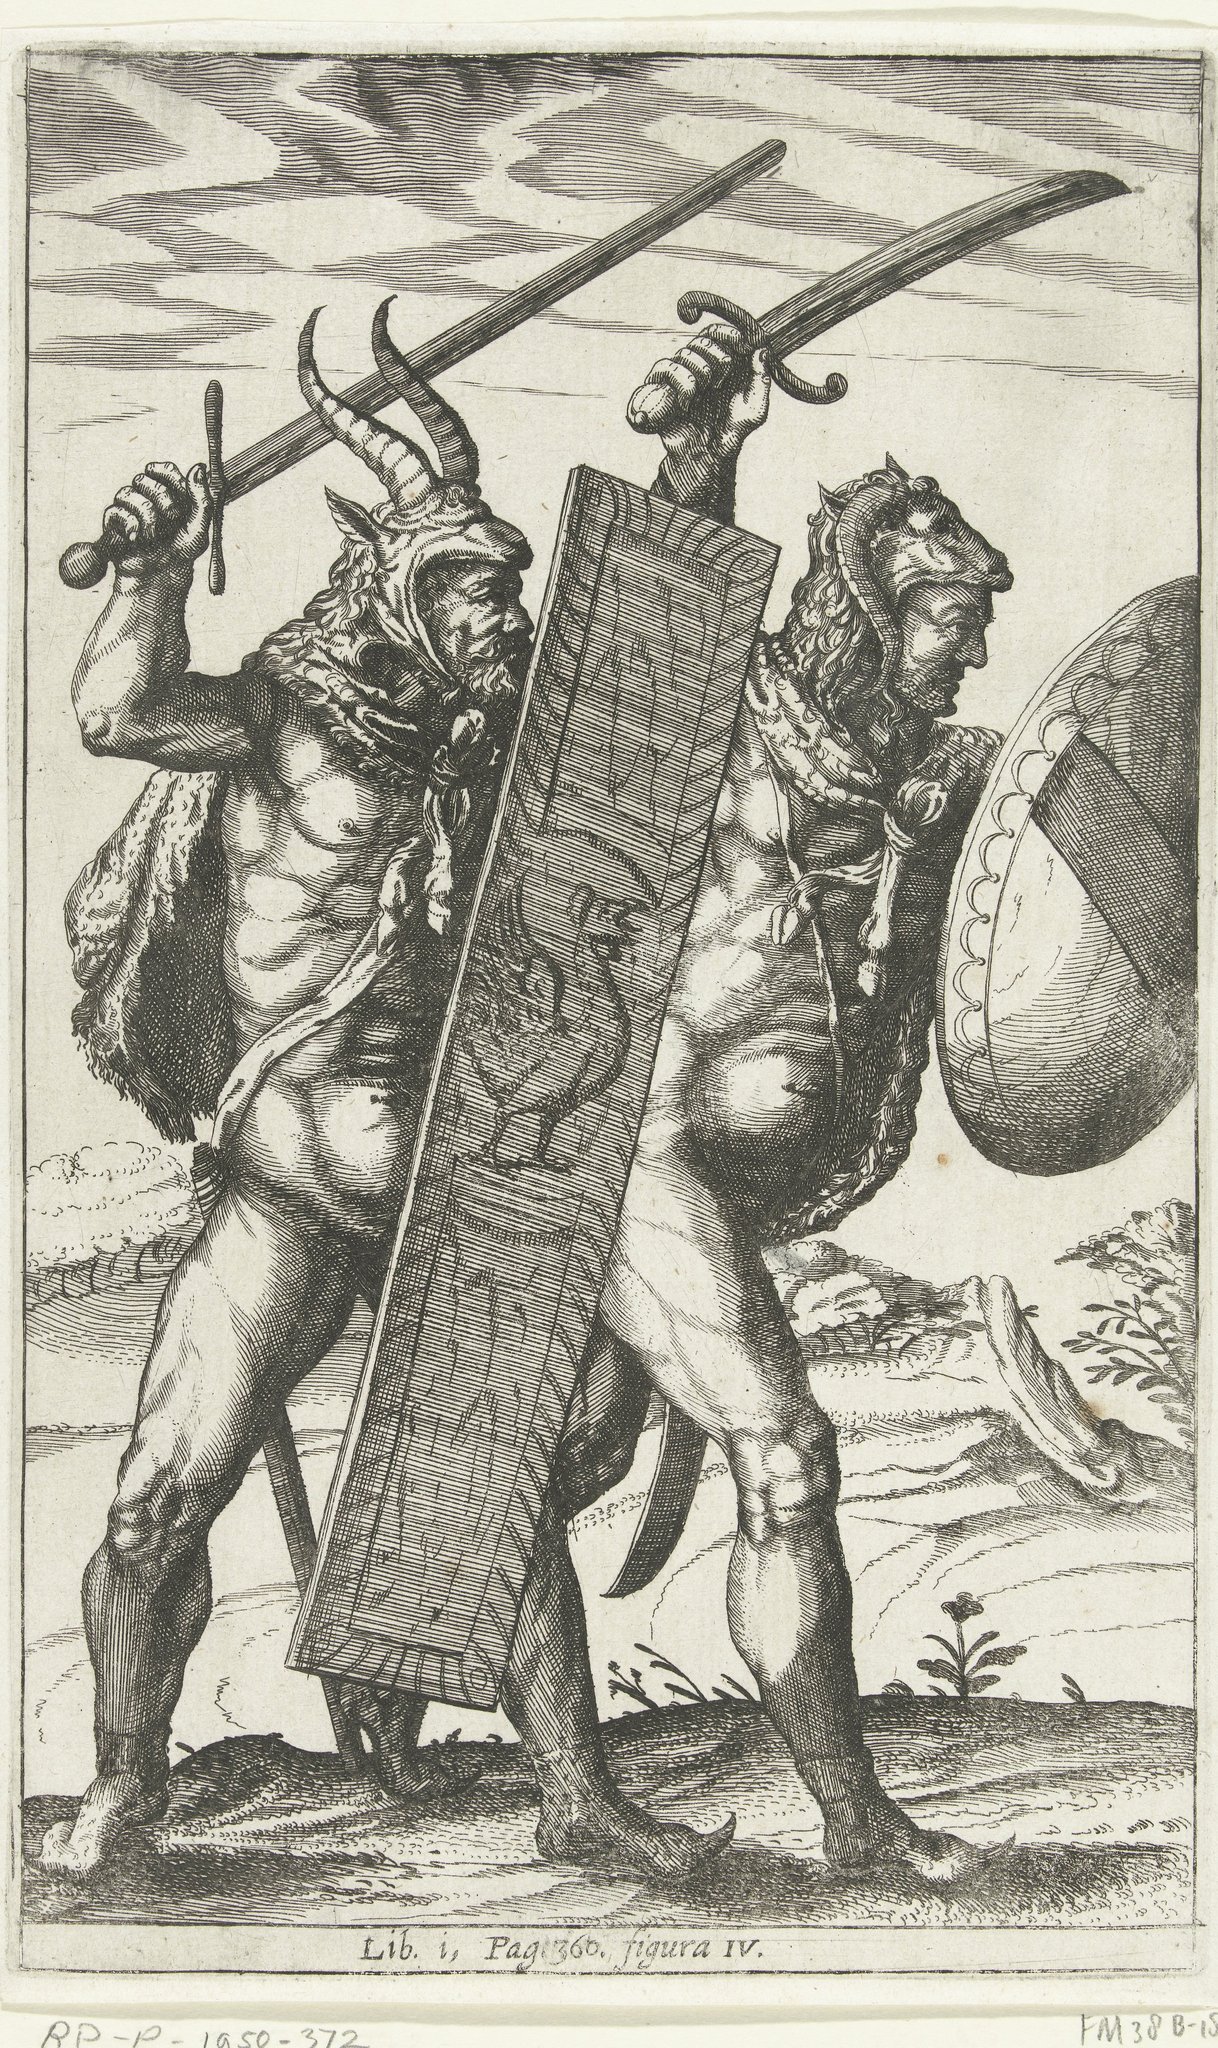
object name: history print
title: Twee Germaanse krijgers, figura IV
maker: nicolaes van geelkercken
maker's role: print maker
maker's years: 1585-1656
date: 1614-1616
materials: paper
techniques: etching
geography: netherlands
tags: the soldier; the soldier's life, extinct, 'historical' peoples (with name)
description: Twee krijgslieden met getrokken zwaarden, één met langwerpig, de ander met rond schild. Afkomstig uit: Philippus Cluverius, Germaniæ antiquæ libri tres, Lowijs (I) Elzevier, Leiden, 1616. Lib. I, Pag. 360, figura IV.